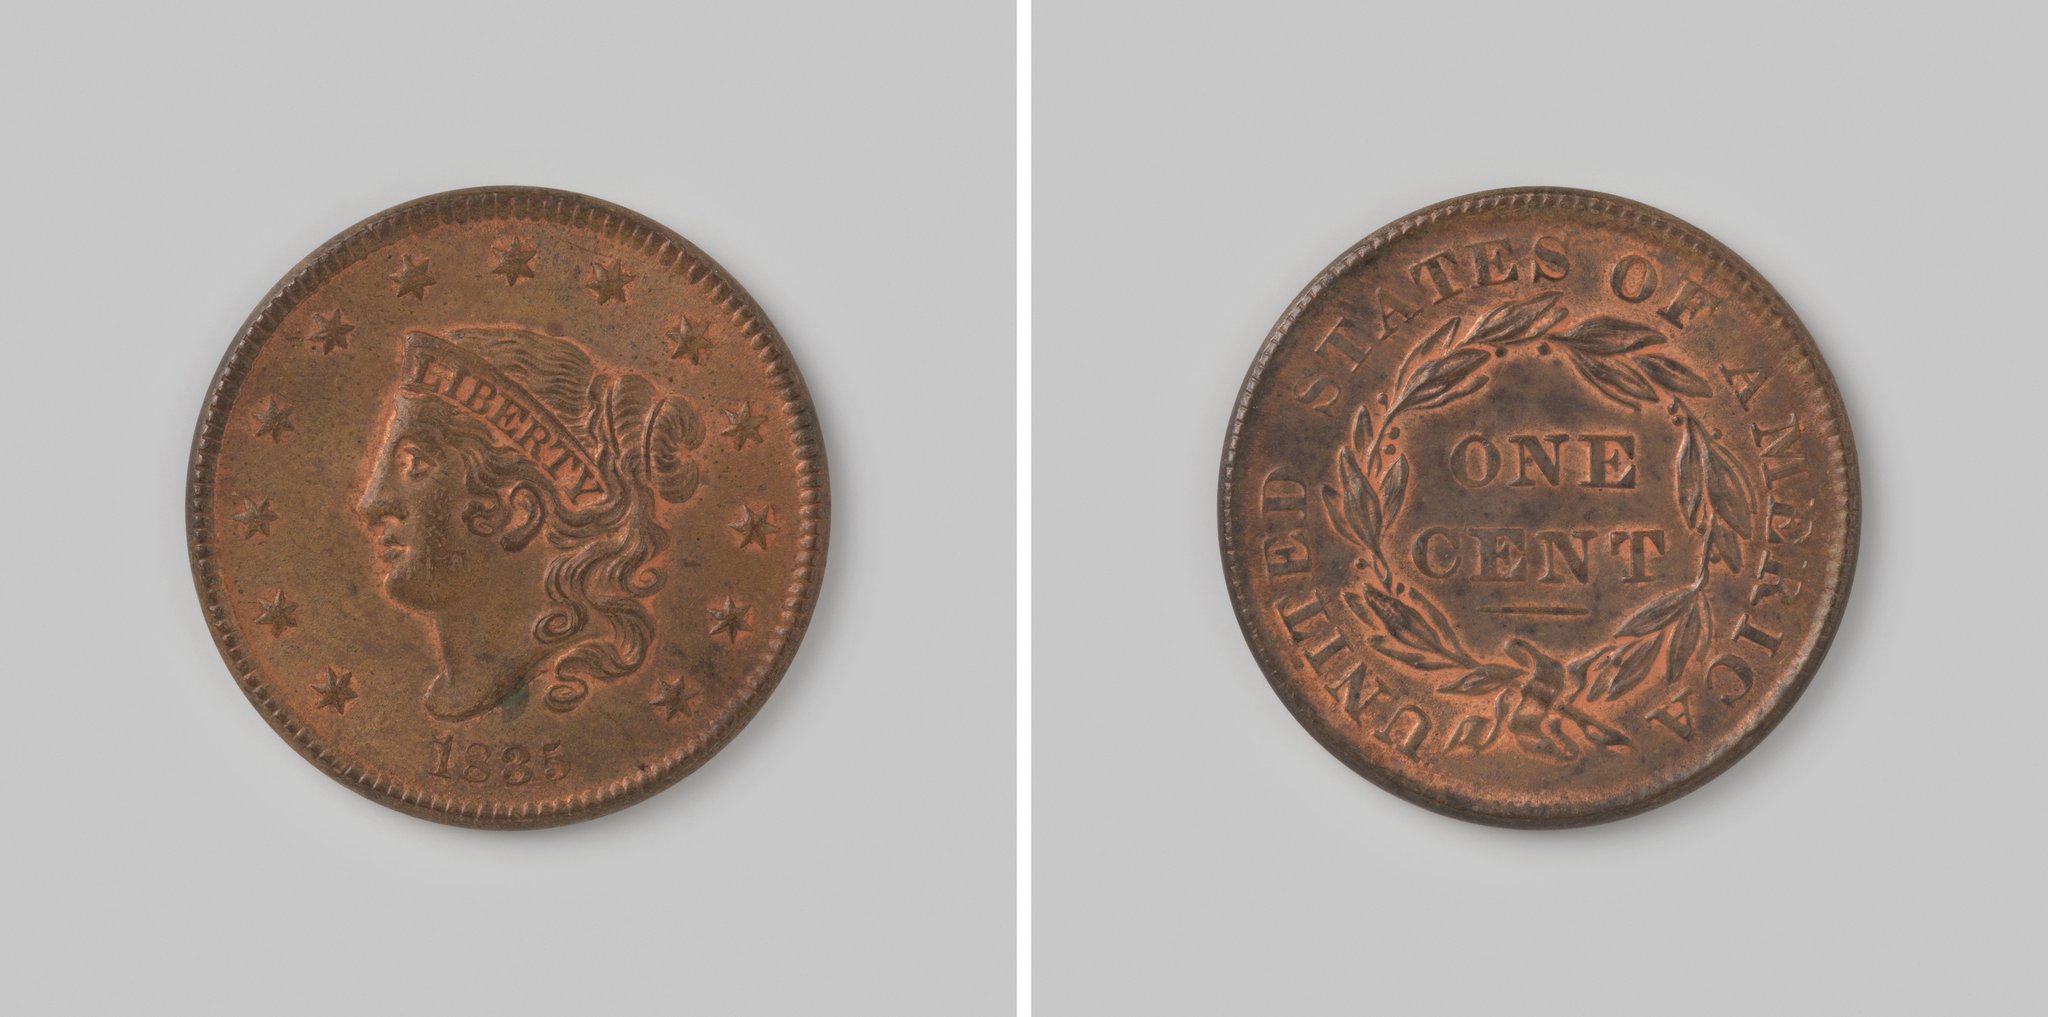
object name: coin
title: Verenigde Staten van Amerika, cent,1835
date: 1835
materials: copper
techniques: striking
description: Koperen munt. Voorzijde: liberty naar links. Rondom haar een rij sterren. Onderaan jaartal. Keerzijde: tussen een in een cirkel geplooide, met een lint vastgebonden, tak waarde-aanduiding: one cent in twee regels. Gladde rand.